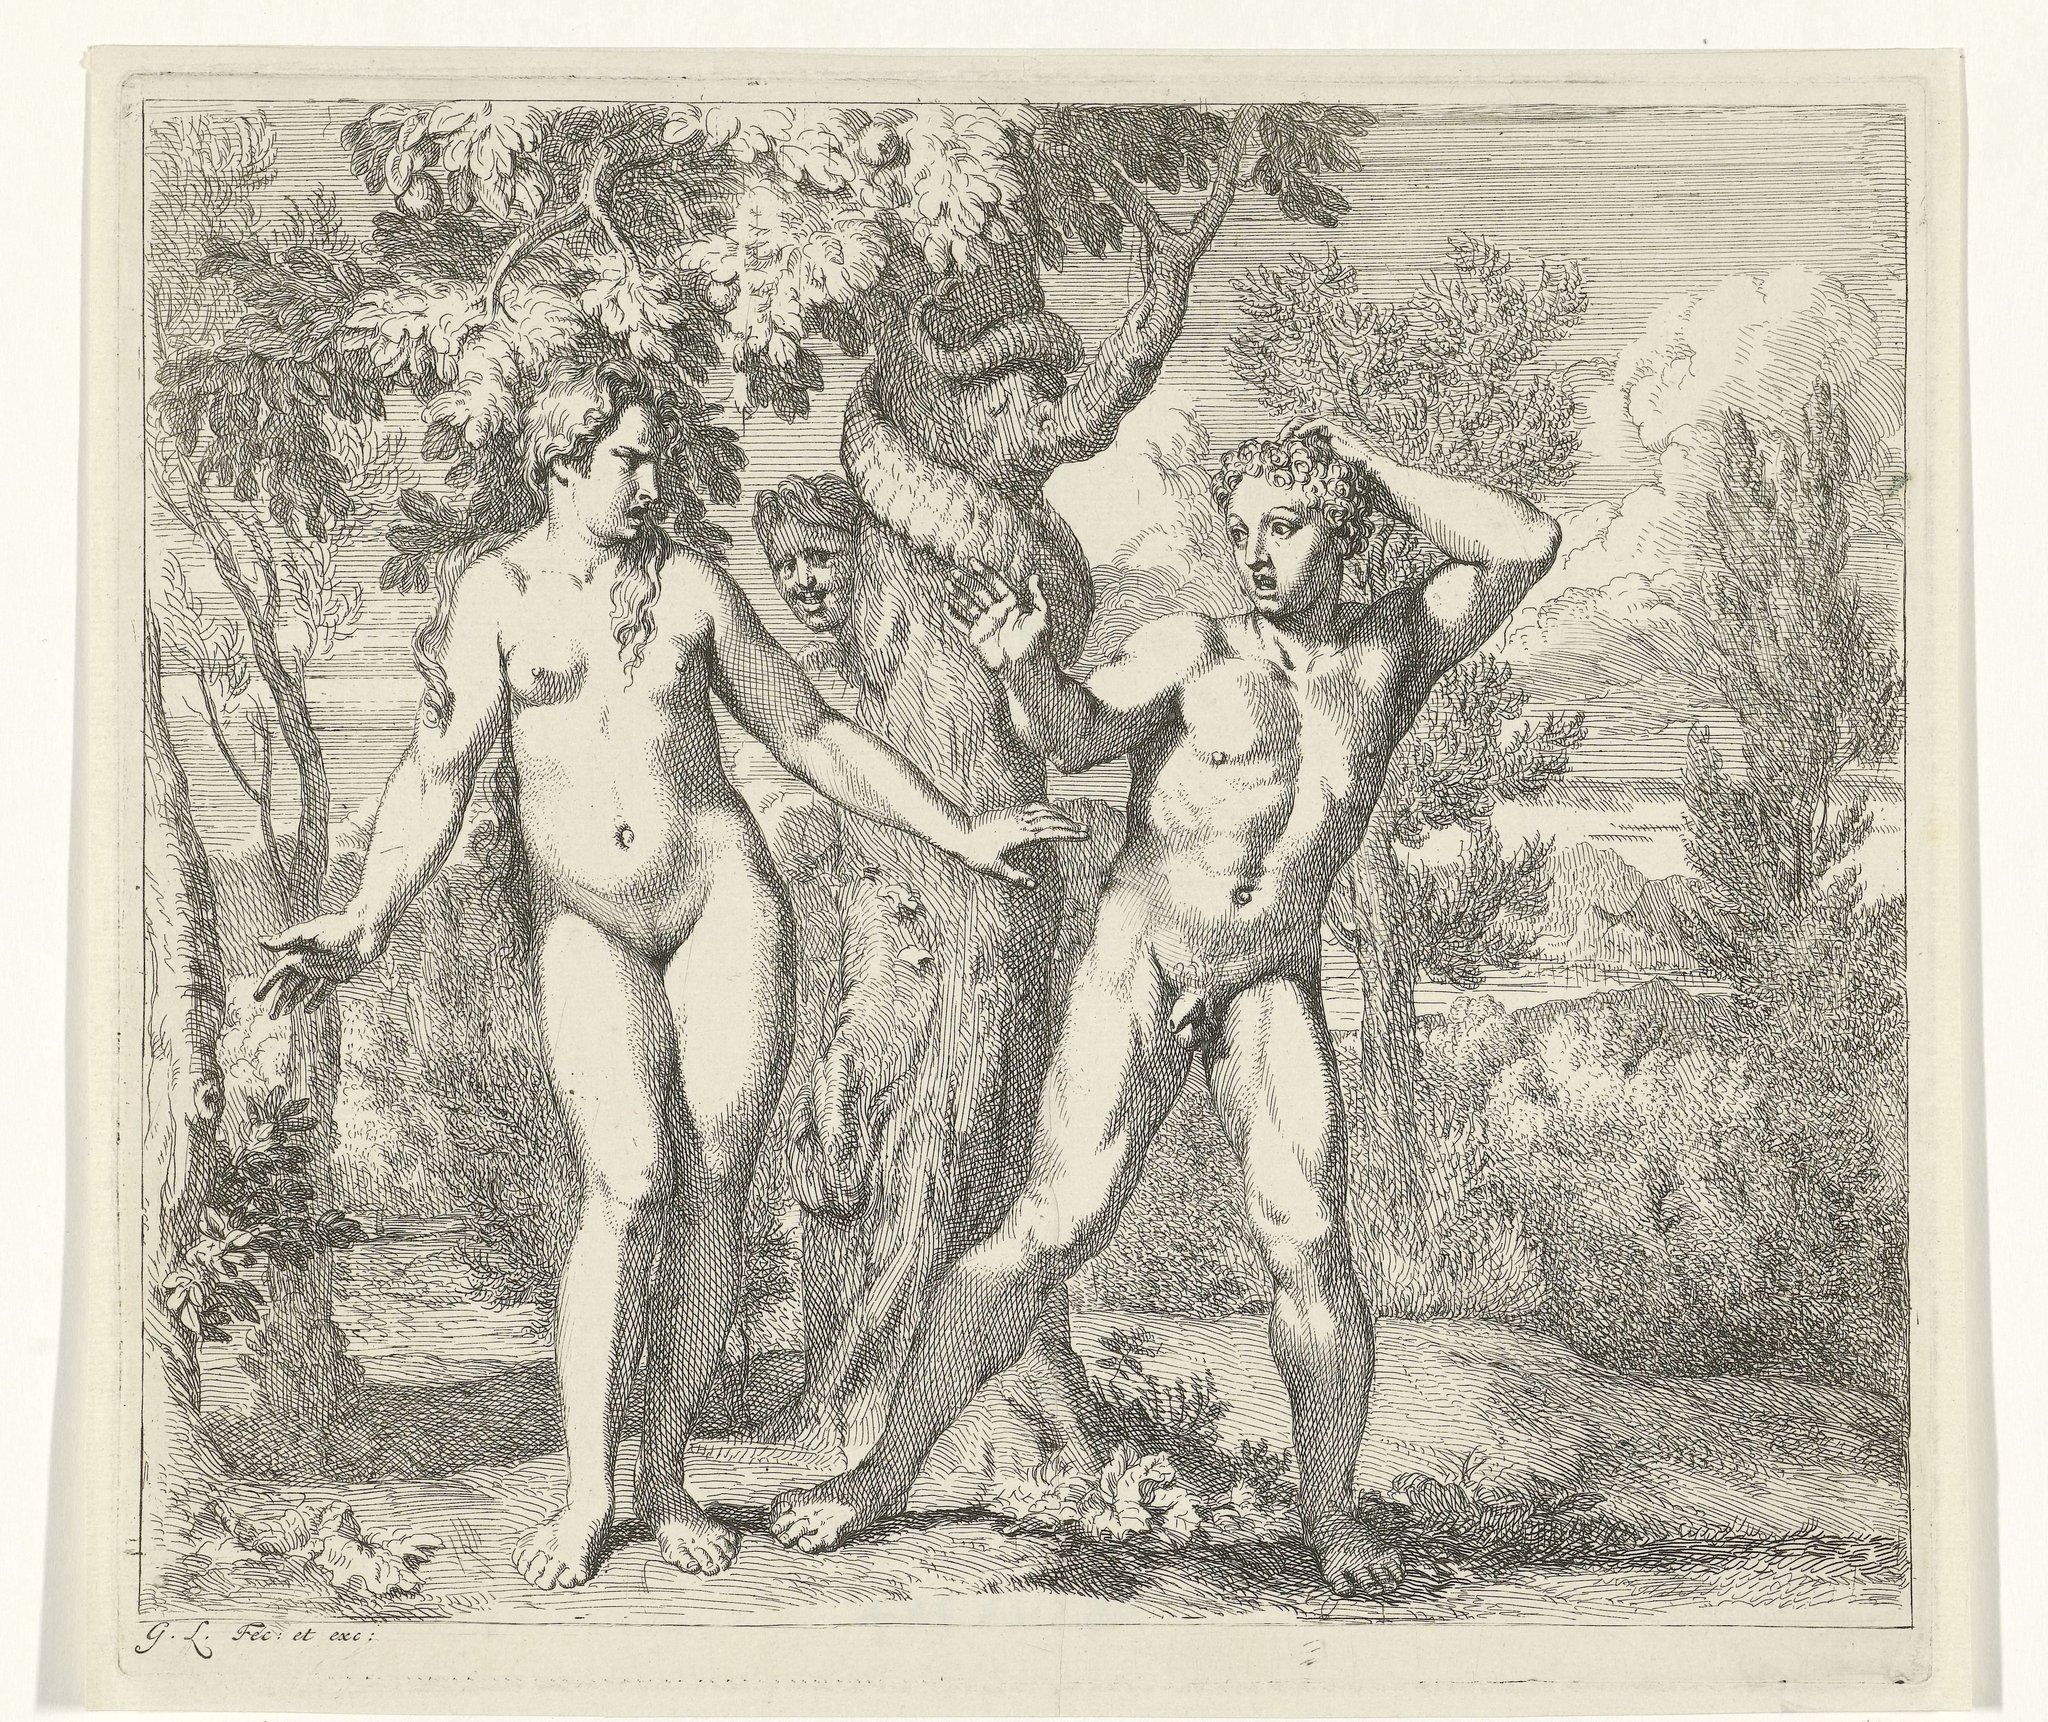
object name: print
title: Scènes uit Genesis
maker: gerard de lairesse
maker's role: draughtsman, painter, print maker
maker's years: 1641-1711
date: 1665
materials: paper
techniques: etching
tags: temptation and fall (scenes with both adam and eve)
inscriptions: collector's mark: Lugt 240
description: Adam en Eva staan in het Paradijs naast de boom der kennis van goed en kwaad. Beiden schrikken van de slang met vrouwenkop die rond de stam van de boom kronkelt. De prent maakt deel uit van een zevendelige serie met scènes uit het Bijbelboek Genesis.